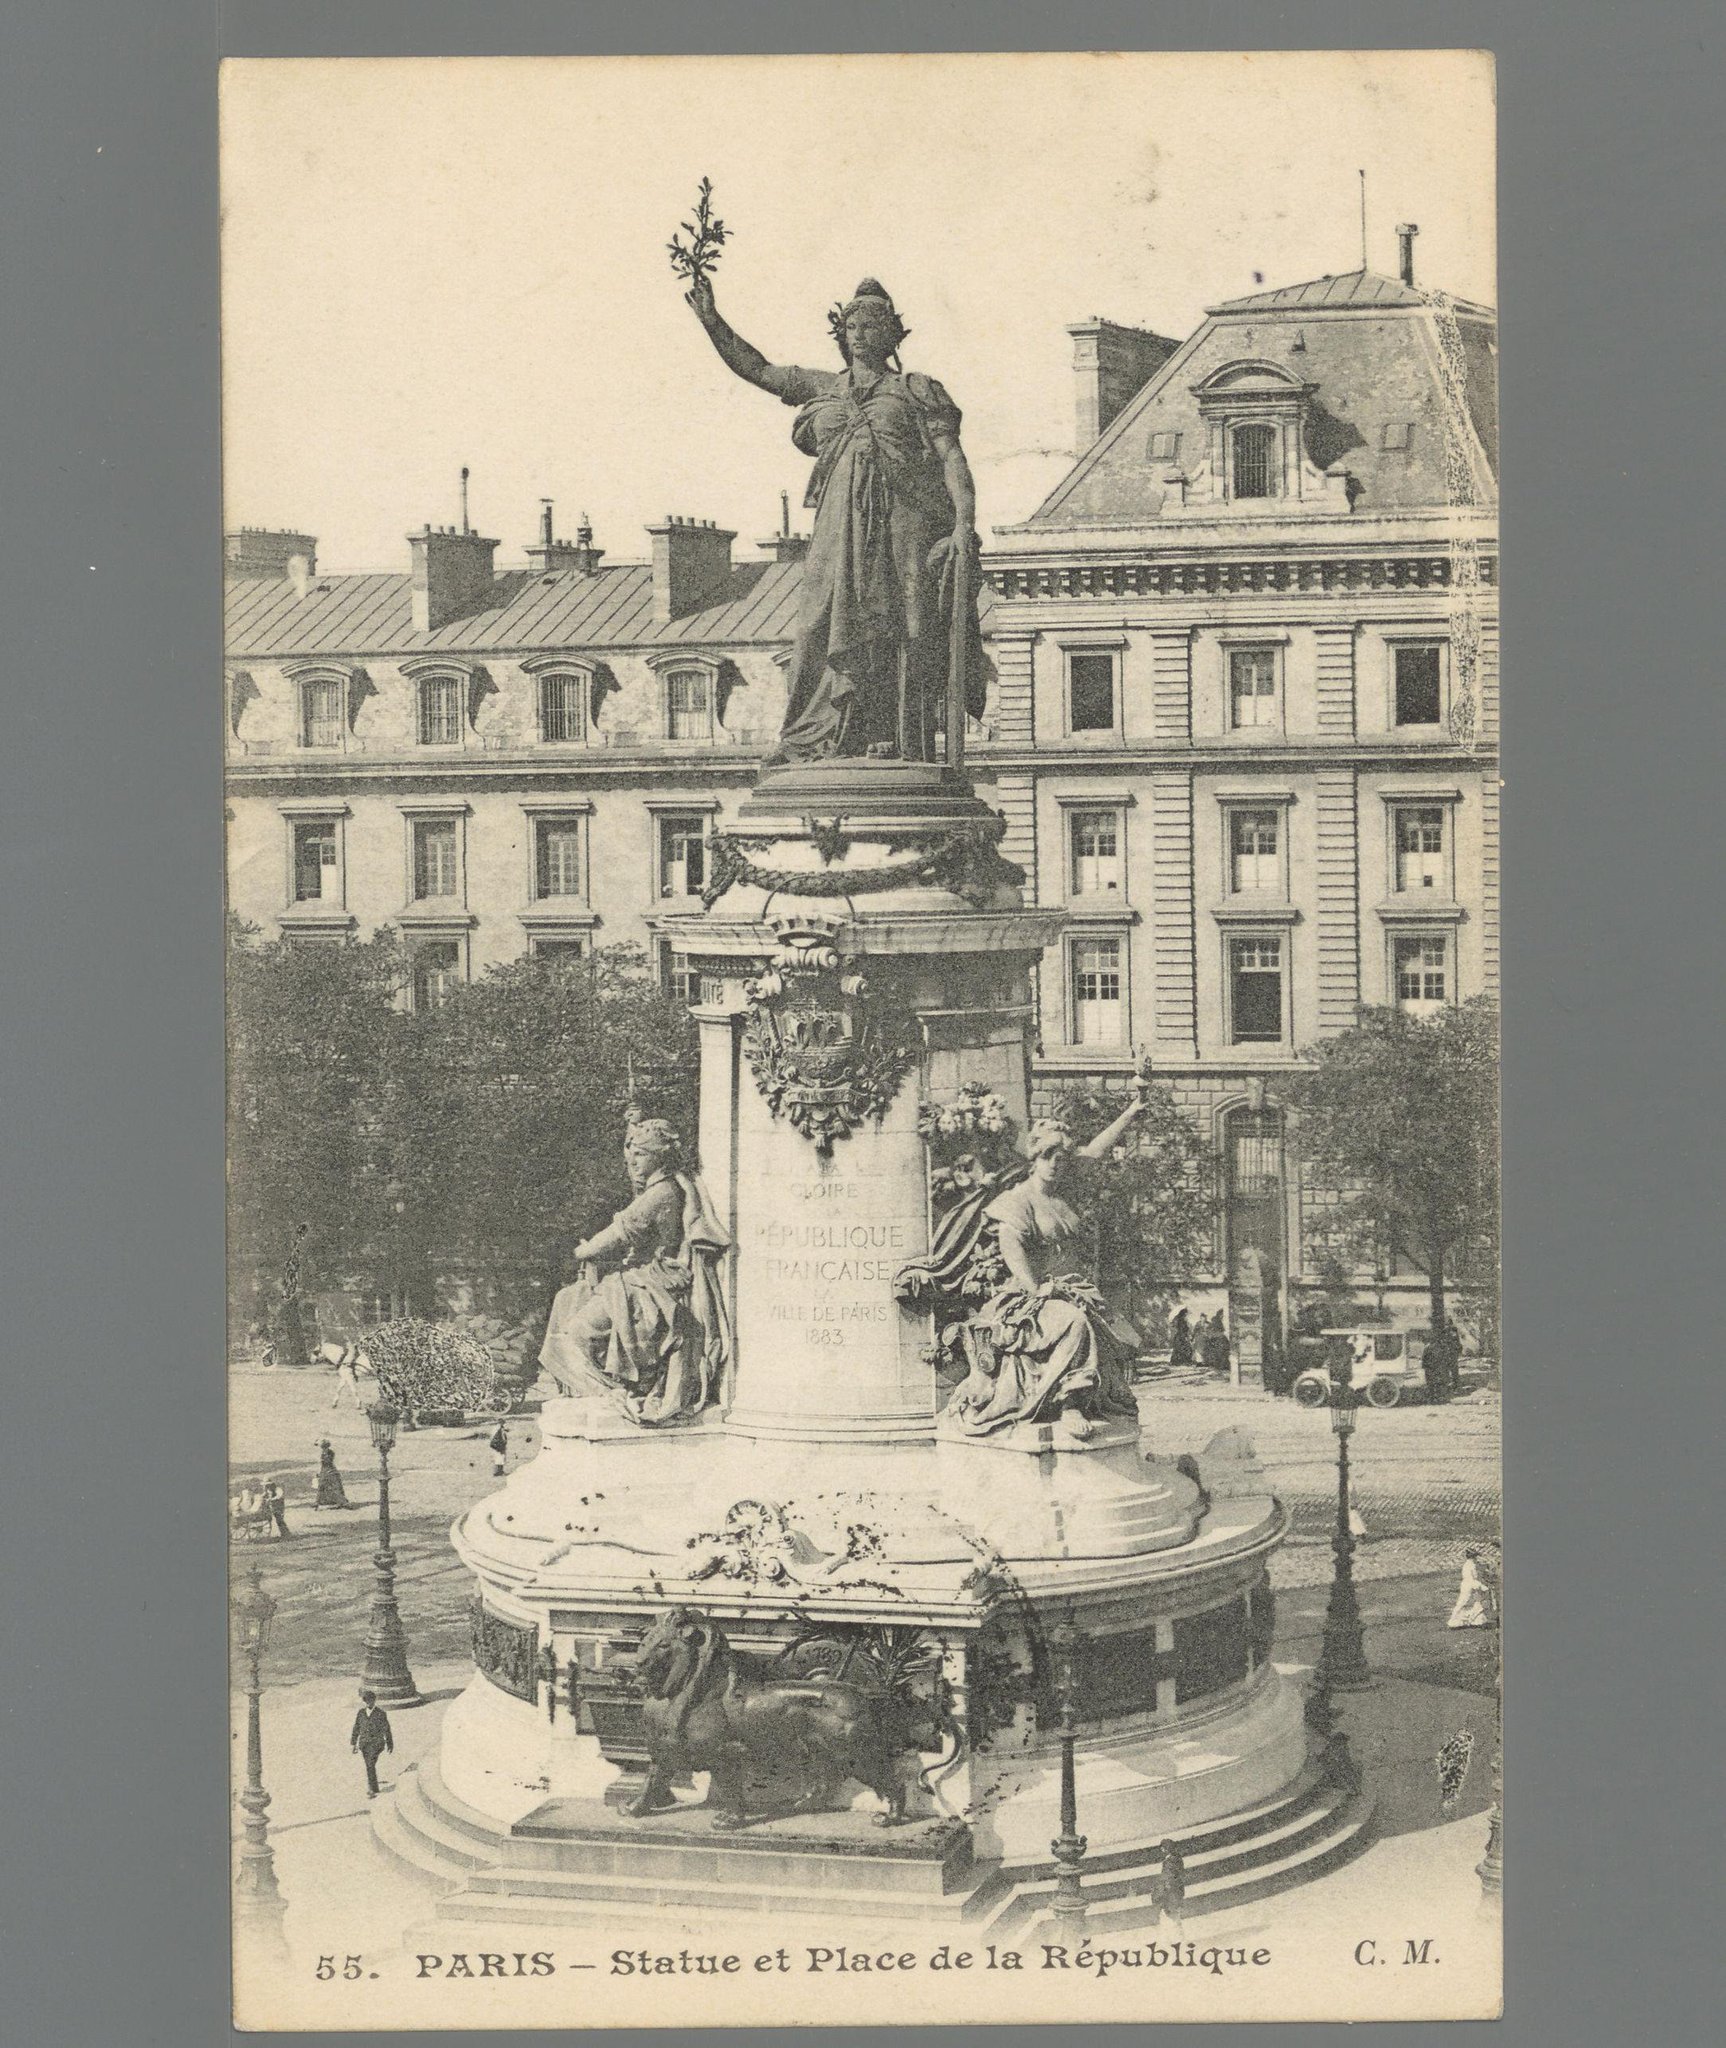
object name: ansichtkaart, prentbriefkaart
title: Paris. Statue et Place de la République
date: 1904-1906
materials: cardboard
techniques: photograph, writing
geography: paris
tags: triumphal arch, city-view, and landscape with man-made constructions (+ city(-scape) with figures, staffage)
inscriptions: postage stamp